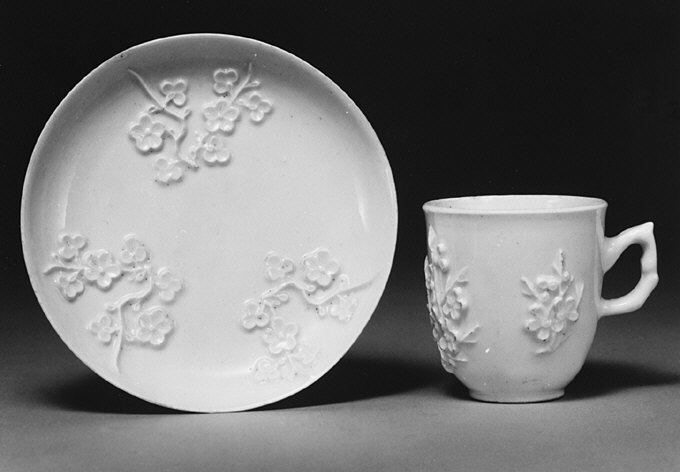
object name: cup and saucer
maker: bow porcelain factory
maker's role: factory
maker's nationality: british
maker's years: 1747-1776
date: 1750-1755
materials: soft paste porcelain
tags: flowers